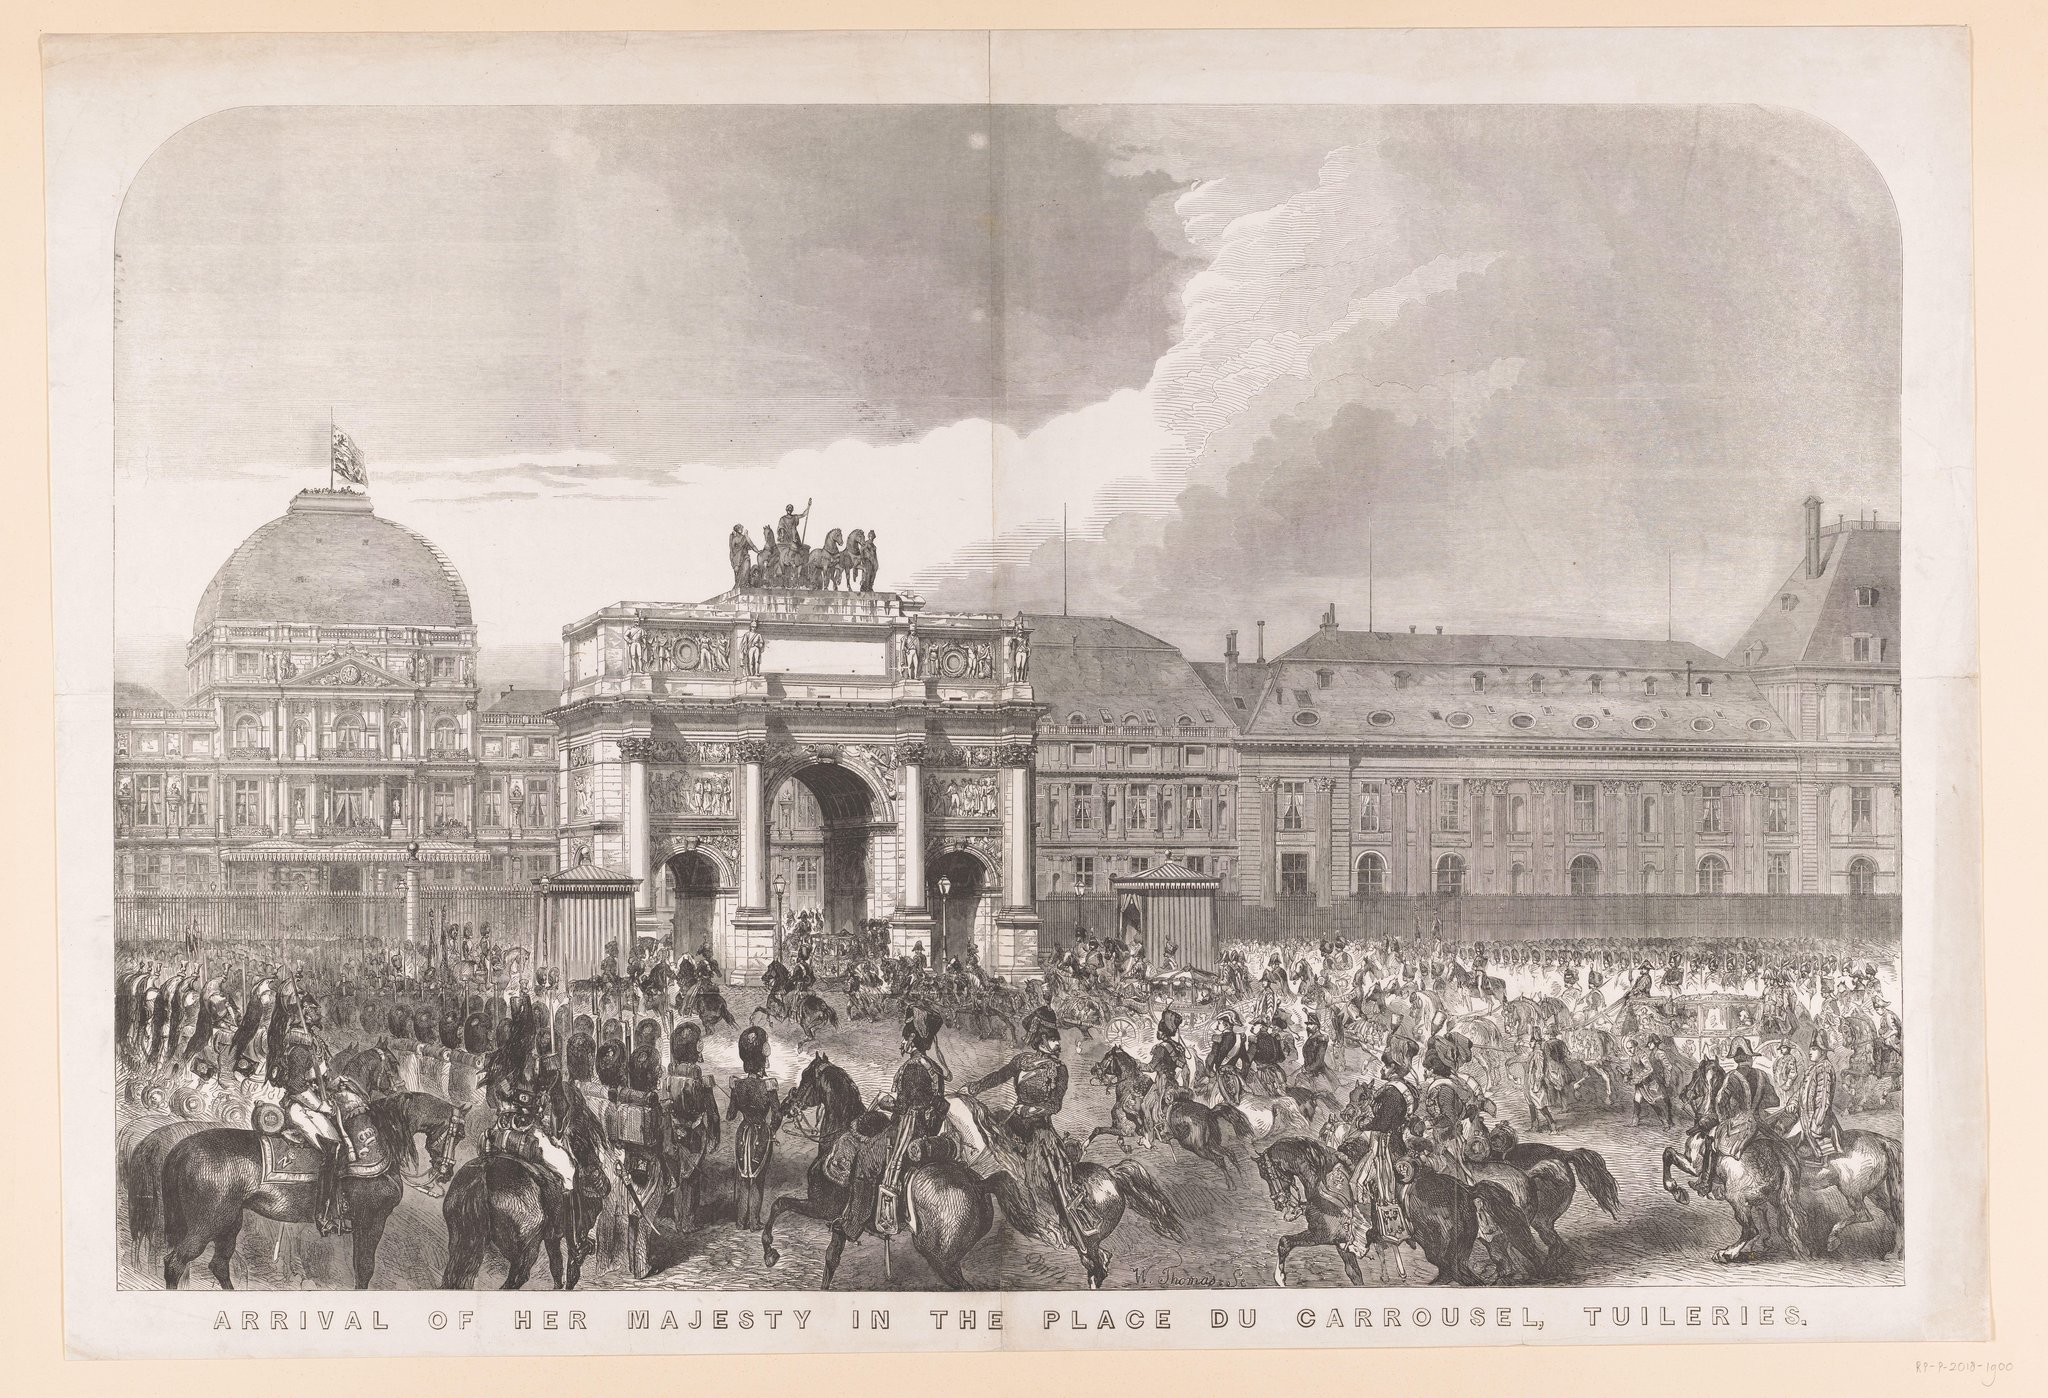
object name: print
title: Arrival of Her Majesty in the Place du Carrousel, Tuileries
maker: walter thomas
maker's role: print maker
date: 1855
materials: paper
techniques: engraving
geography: england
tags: victoria (koningin van het verenigd koninkrijk en keizerin van india), public festivities on the occasion of royal events, triumphal arch, ornamental fountain, paris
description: Het koninklijk bezoek van de Britse koningin Victoria aan Napoleon III (17-28 augustus 1855). Aankomst van het rijtuig met de koningin bij de Arc de Triomphe du Carrousel in Parijs, augustus 1855.